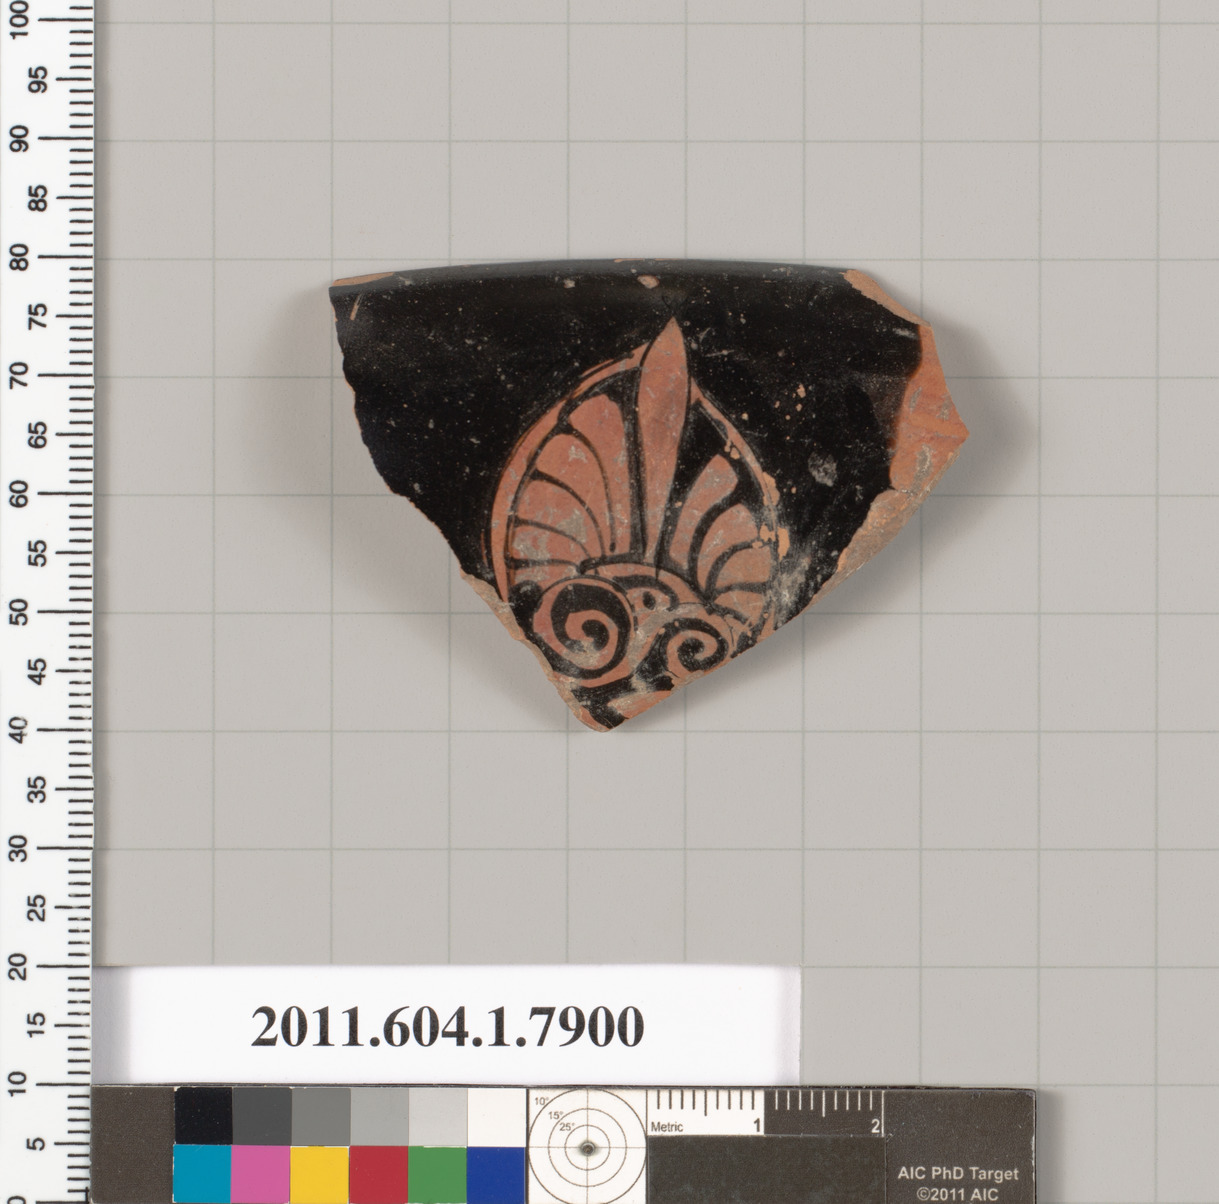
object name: kylix fragment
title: Terracotta rim fragment of a kylix (drinking cup)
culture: greek, attic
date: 450 BCE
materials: terracotta